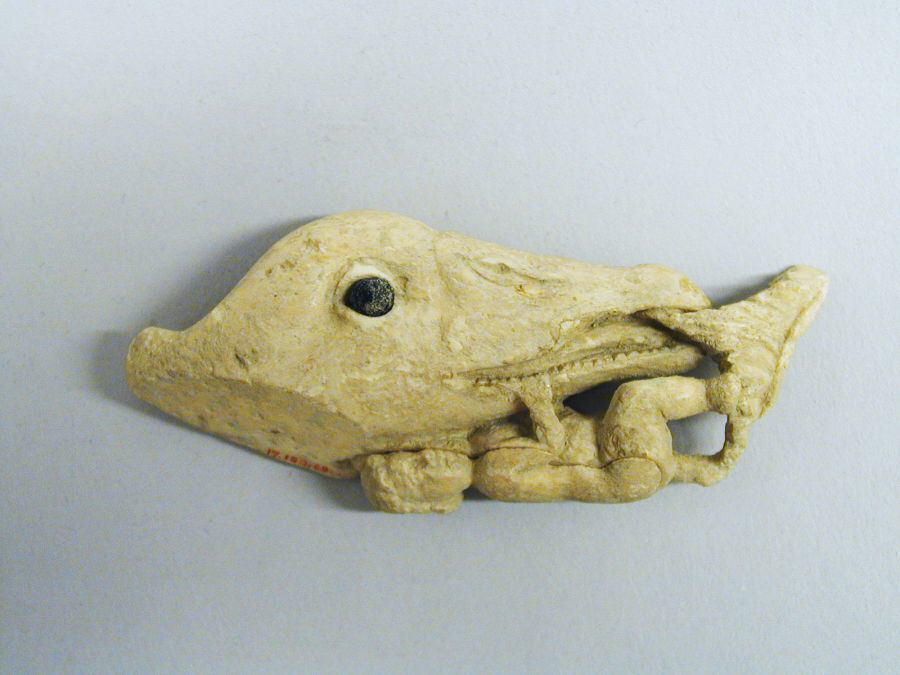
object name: relief from couch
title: Ivory furniture attachment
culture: roman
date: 1-33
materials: ivory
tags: ducks,cupid